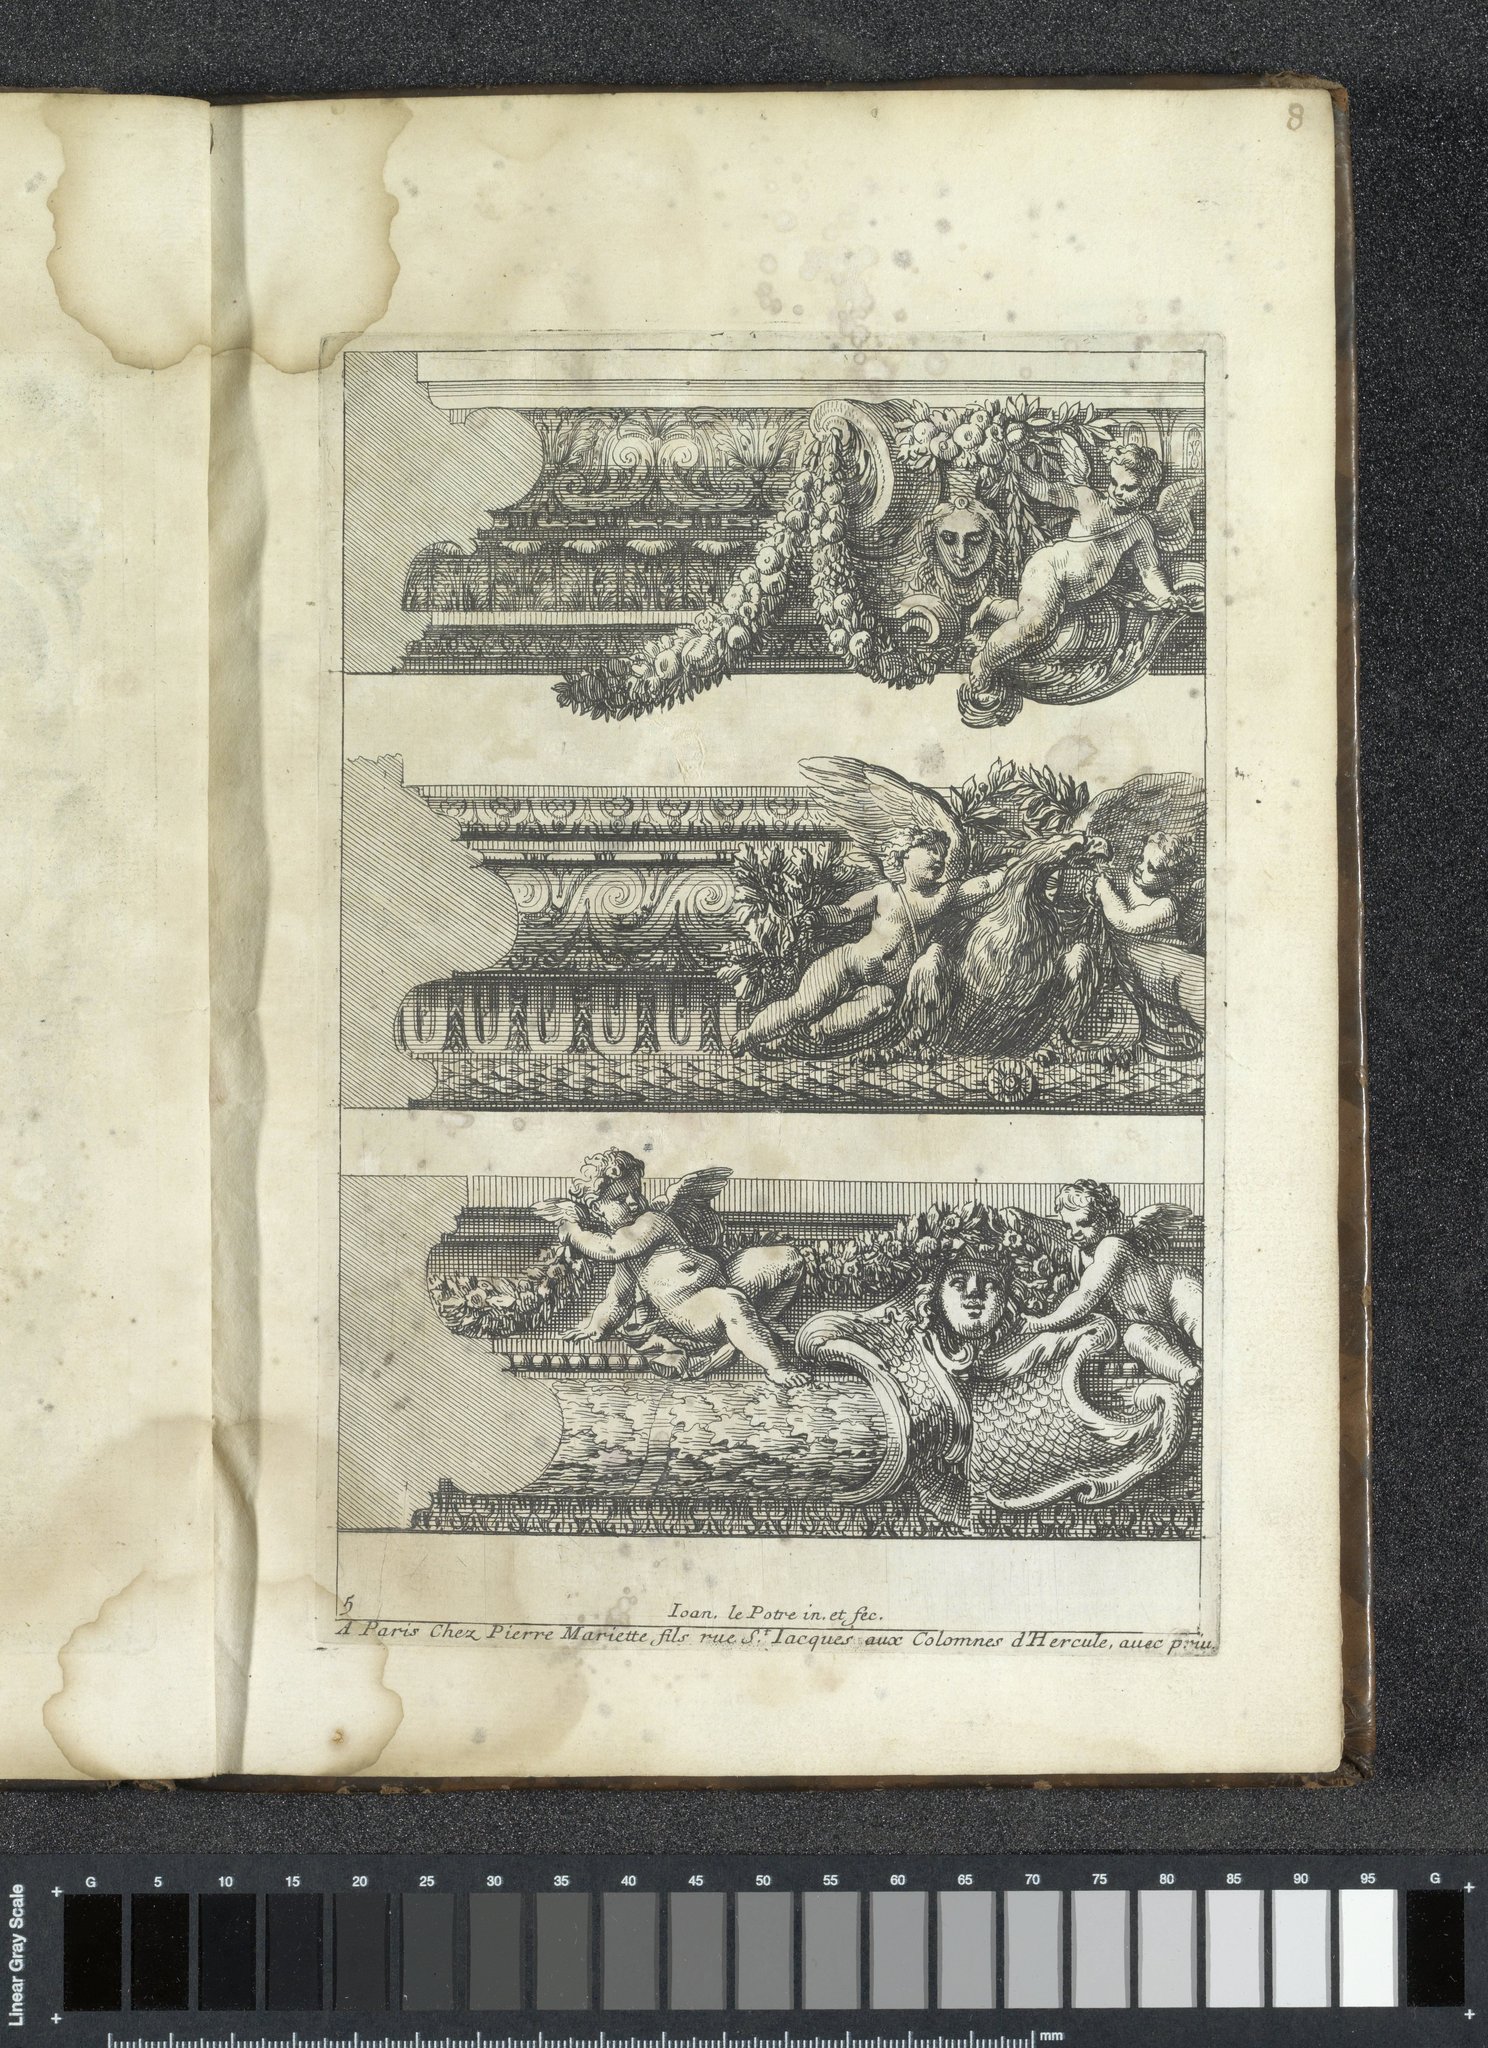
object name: print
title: Bordures de Tableau a la Romaine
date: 1655-1657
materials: paper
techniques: etching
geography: paris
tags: ornaments ~ art, ornament ~ festoon, garland, cupids: 'amores', 'amoretti', 'putti'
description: De middelste lijst met een adelaar geflankeerd door twee kinderen. Prent maakt deel uit van een album.